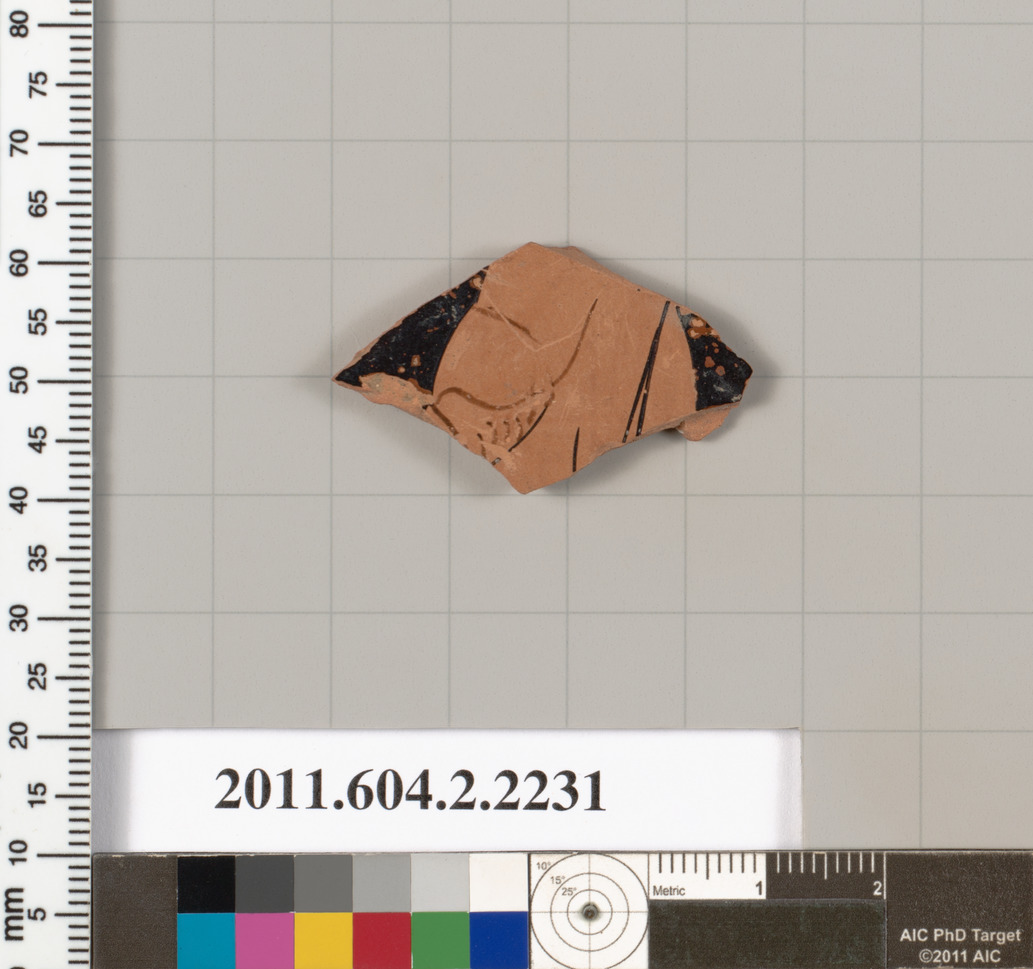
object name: pot fragment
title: Terracotta fragment of a pot; unglazed on the inside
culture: greek, attic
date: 475-451 BCE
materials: terracotta